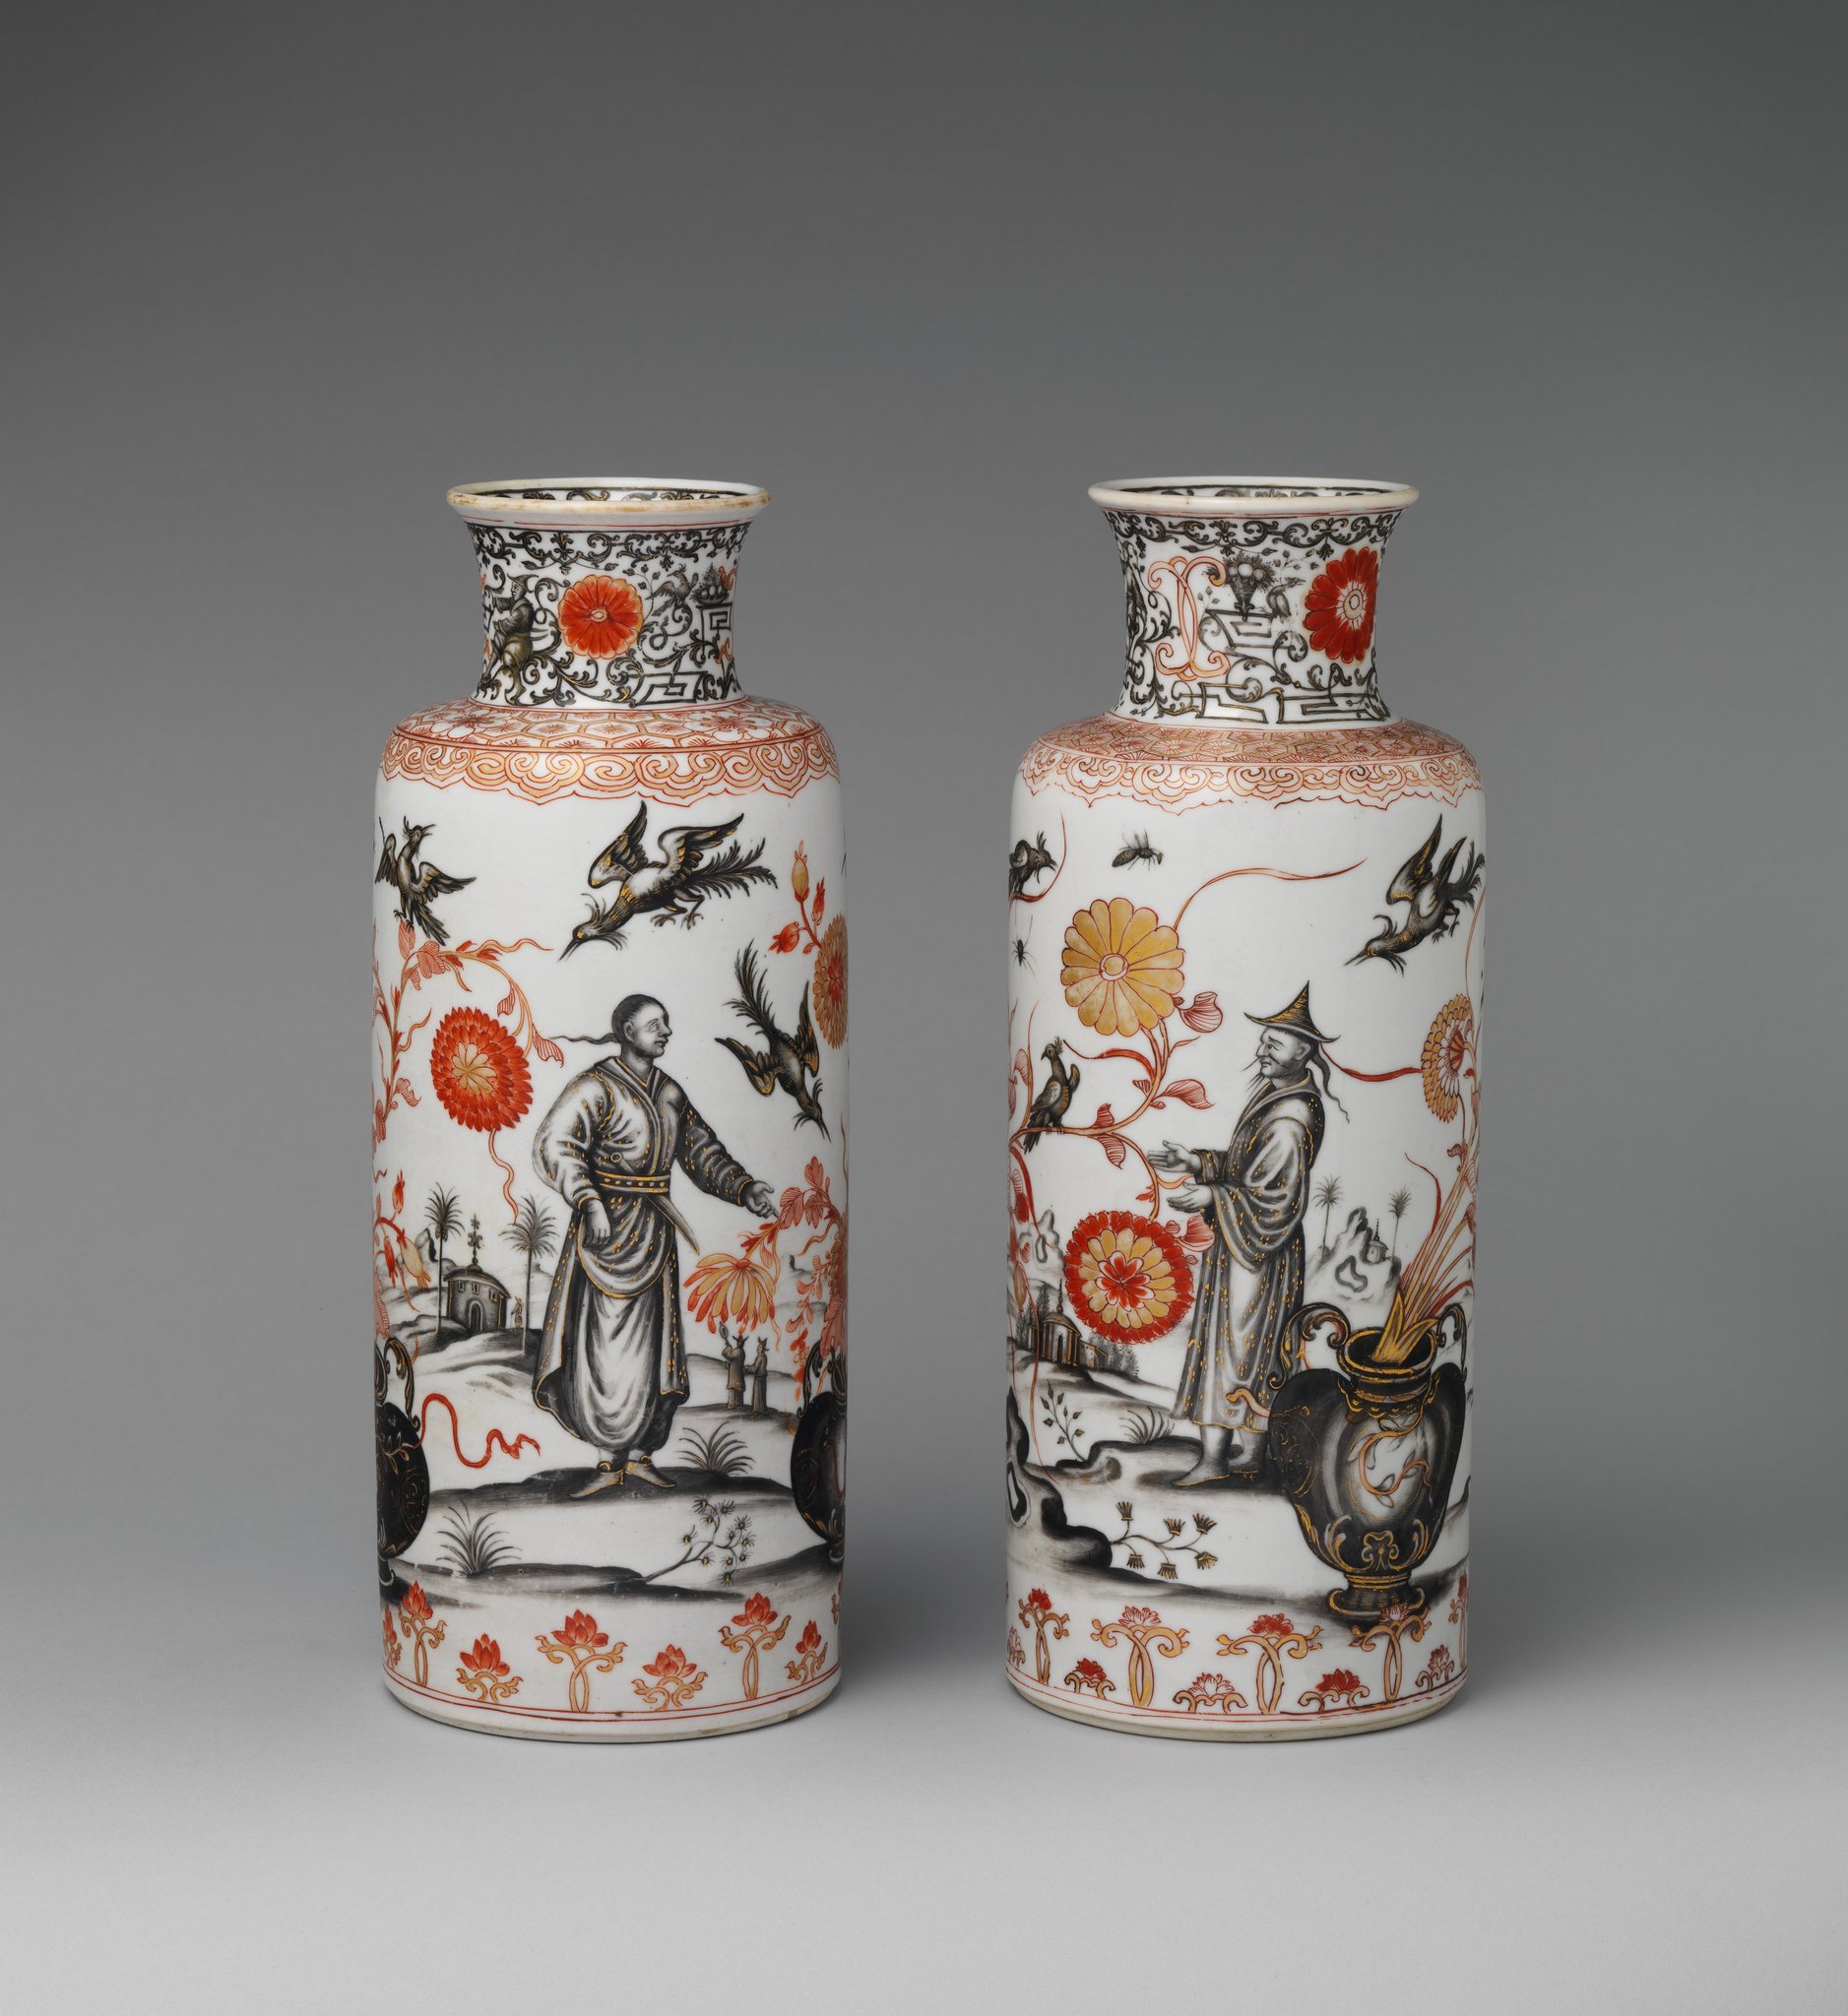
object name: vase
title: Vase (one of a pair)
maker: ignaz preissler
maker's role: decorator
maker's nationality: bohemian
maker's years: 1676-1741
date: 1701-1733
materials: hard paste porcelain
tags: birds,chinoiserie,men,flowers